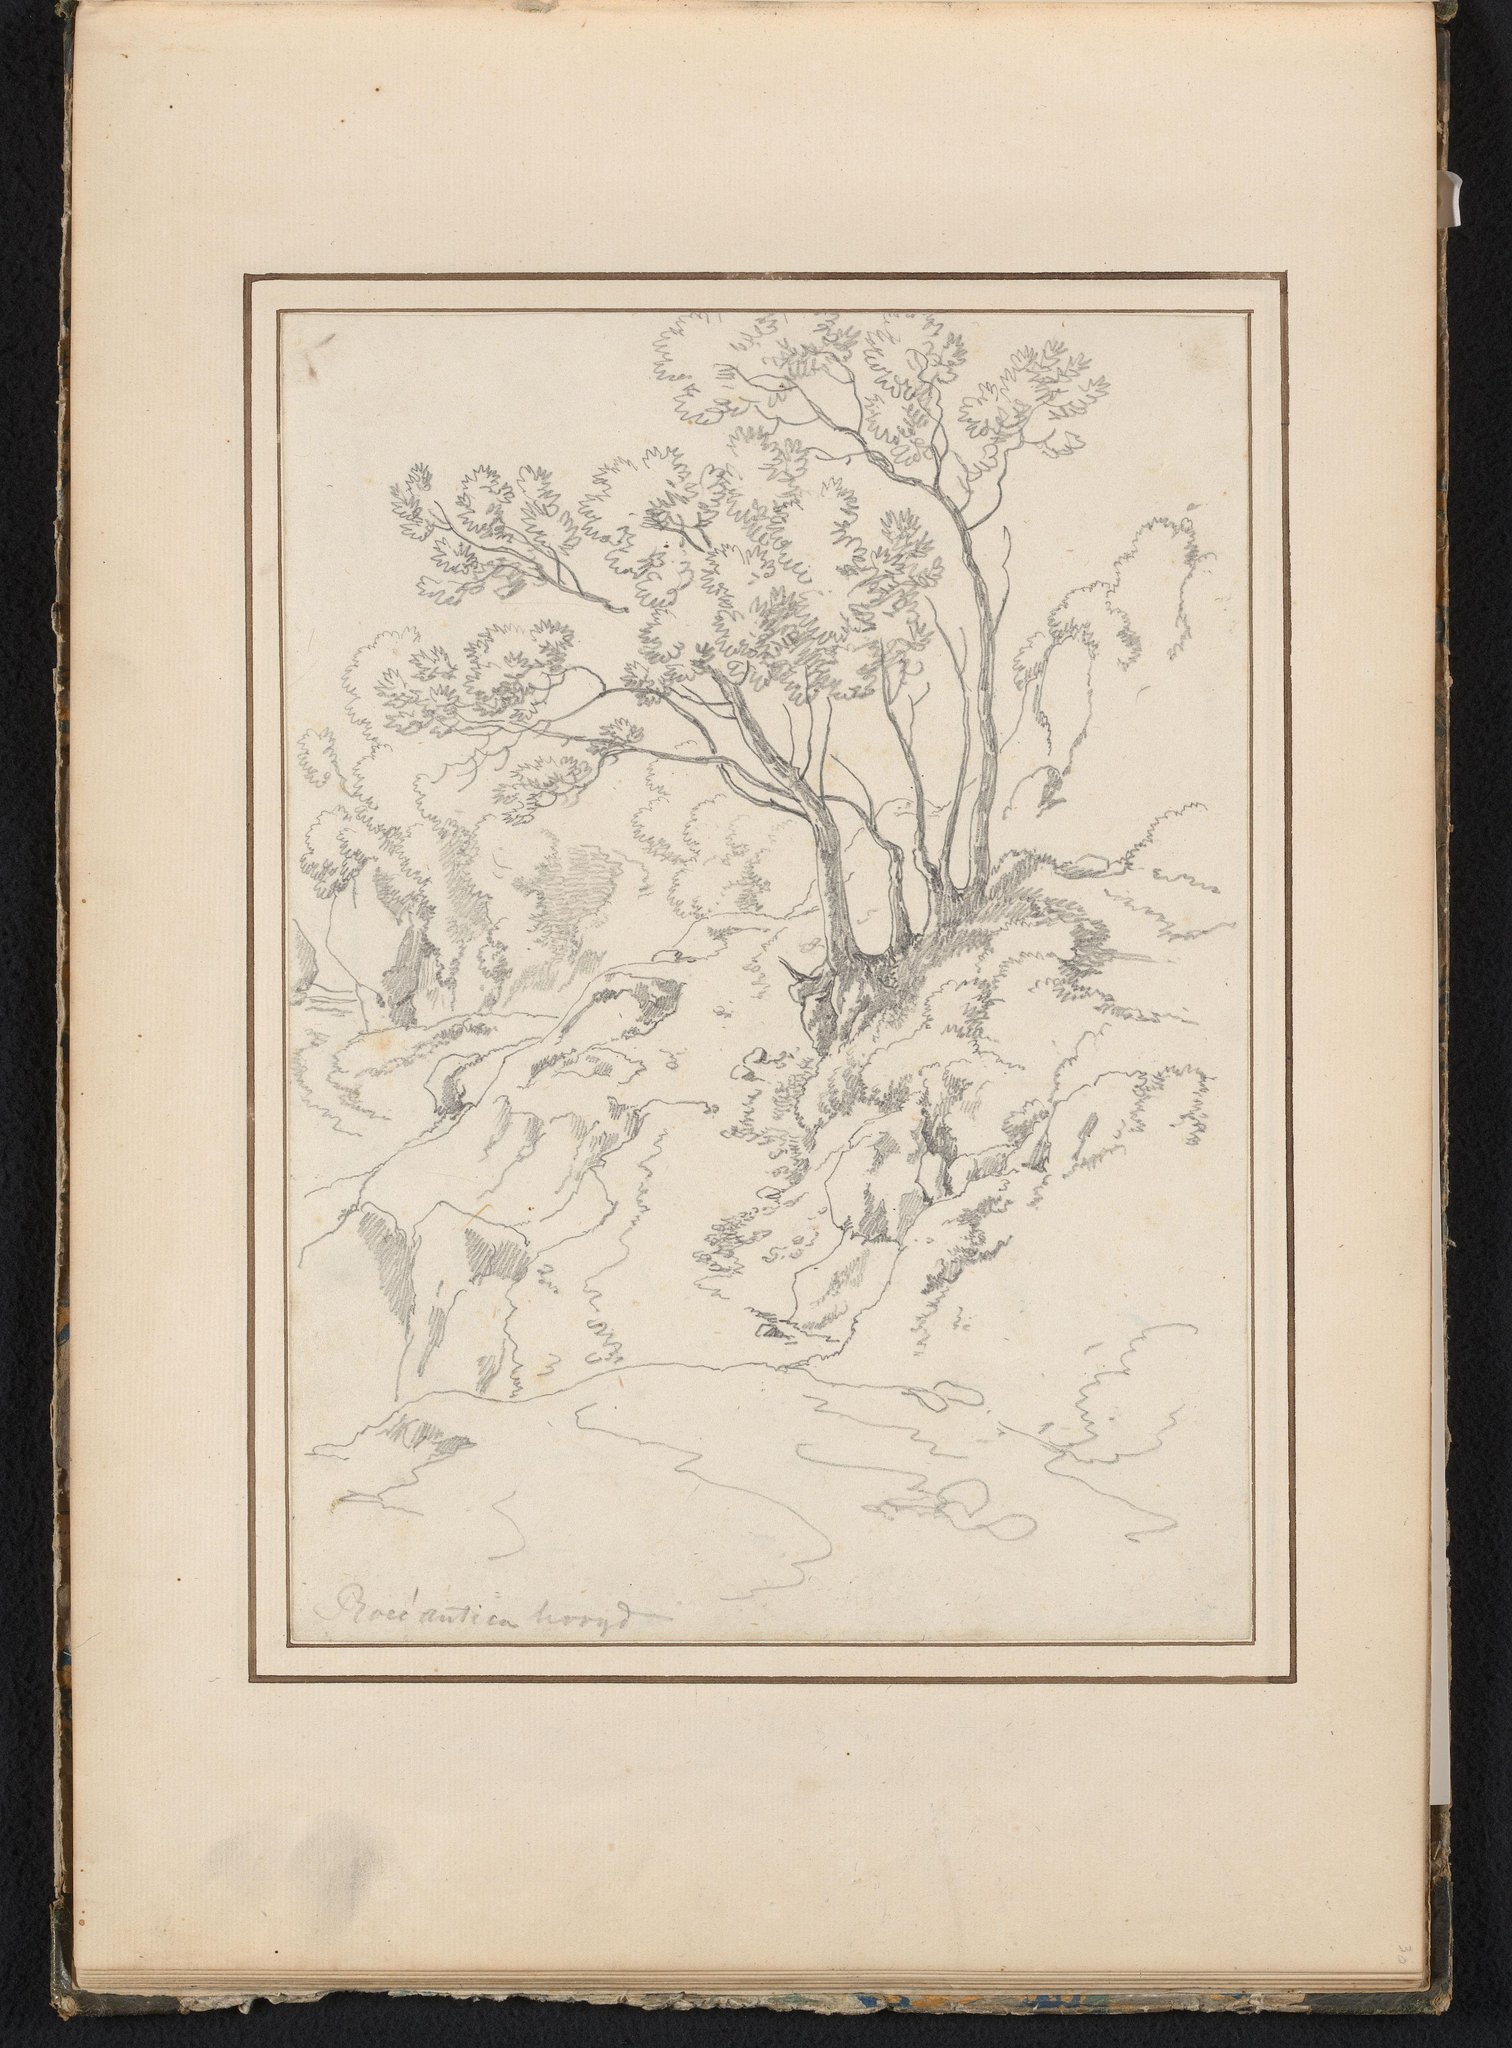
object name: drawing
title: Heuvellandschap met bomen te Roccantica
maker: hendrik voogd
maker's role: draughtsman, painter, print maker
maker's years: 1768-1839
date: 1788-1839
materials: paper, pencil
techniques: pasting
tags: low hill country, groups of trees, roccantica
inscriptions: inscription: ‘Rocc'antica’